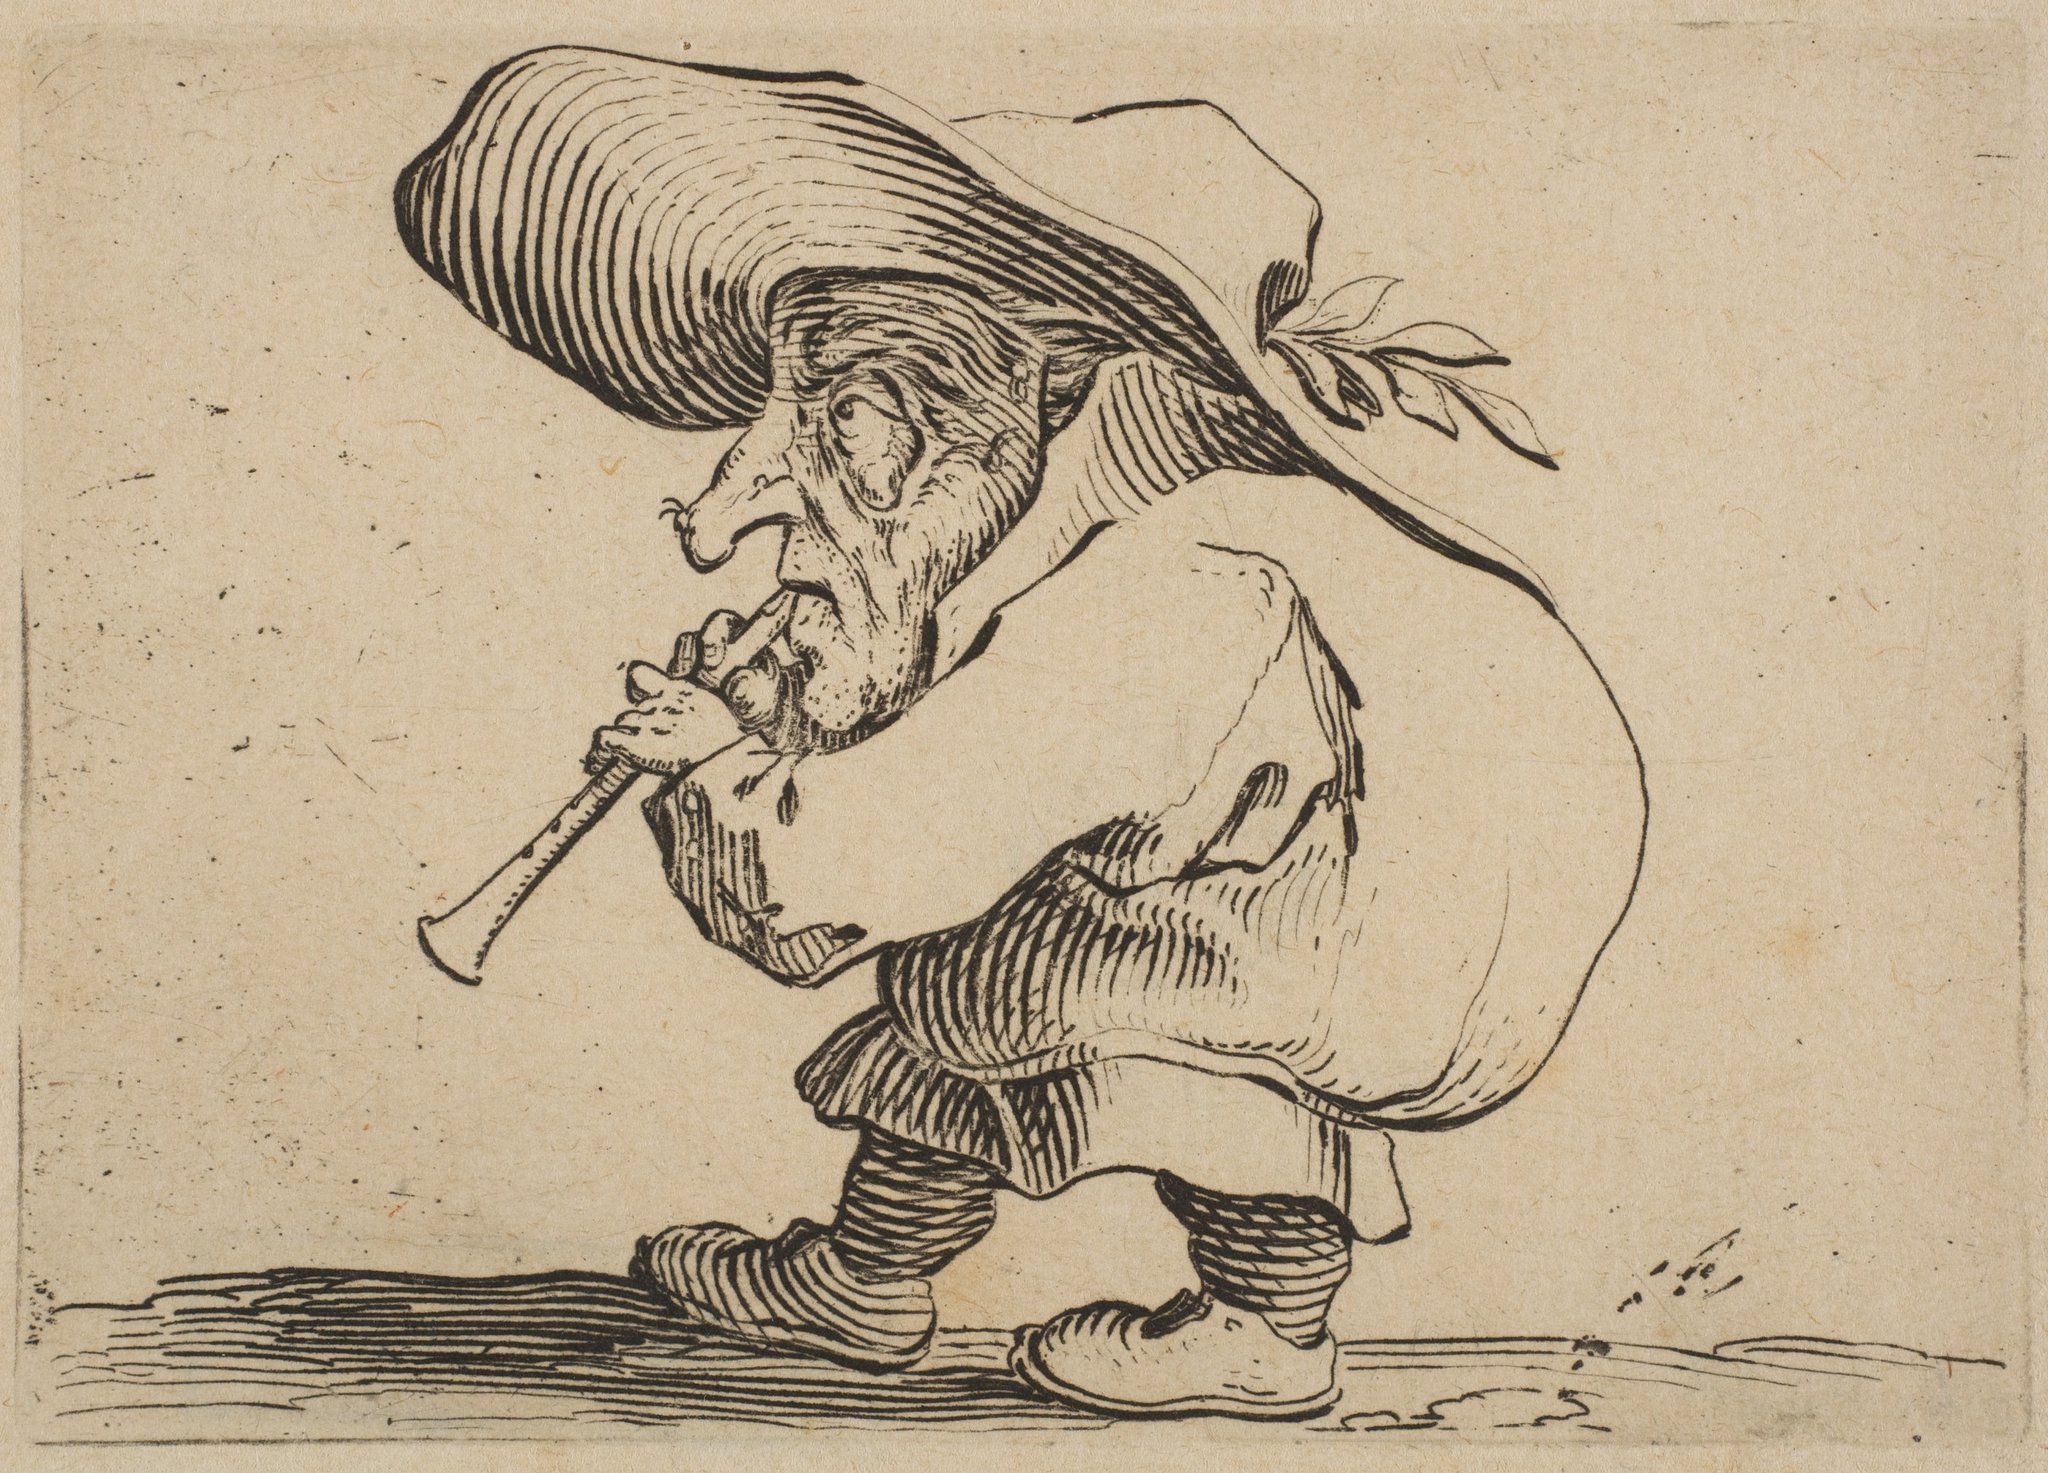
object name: print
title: Le Joueur de Flageolet (The Flageolet Player), from "Varie Figure Gobbi, suite appelée aussi Les Bossus, Les Pygmées, Les Nains Grotesques" (Various Hunchbacked Figures, The Hunchbacks, The Pygmes, The Grotesque Dwarfs)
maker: jacques callot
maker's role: artist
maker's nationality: french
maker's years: 1592-1635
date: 1616-1622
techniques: engraving, etching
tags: musical instruments,men,mythical creatures,musicians